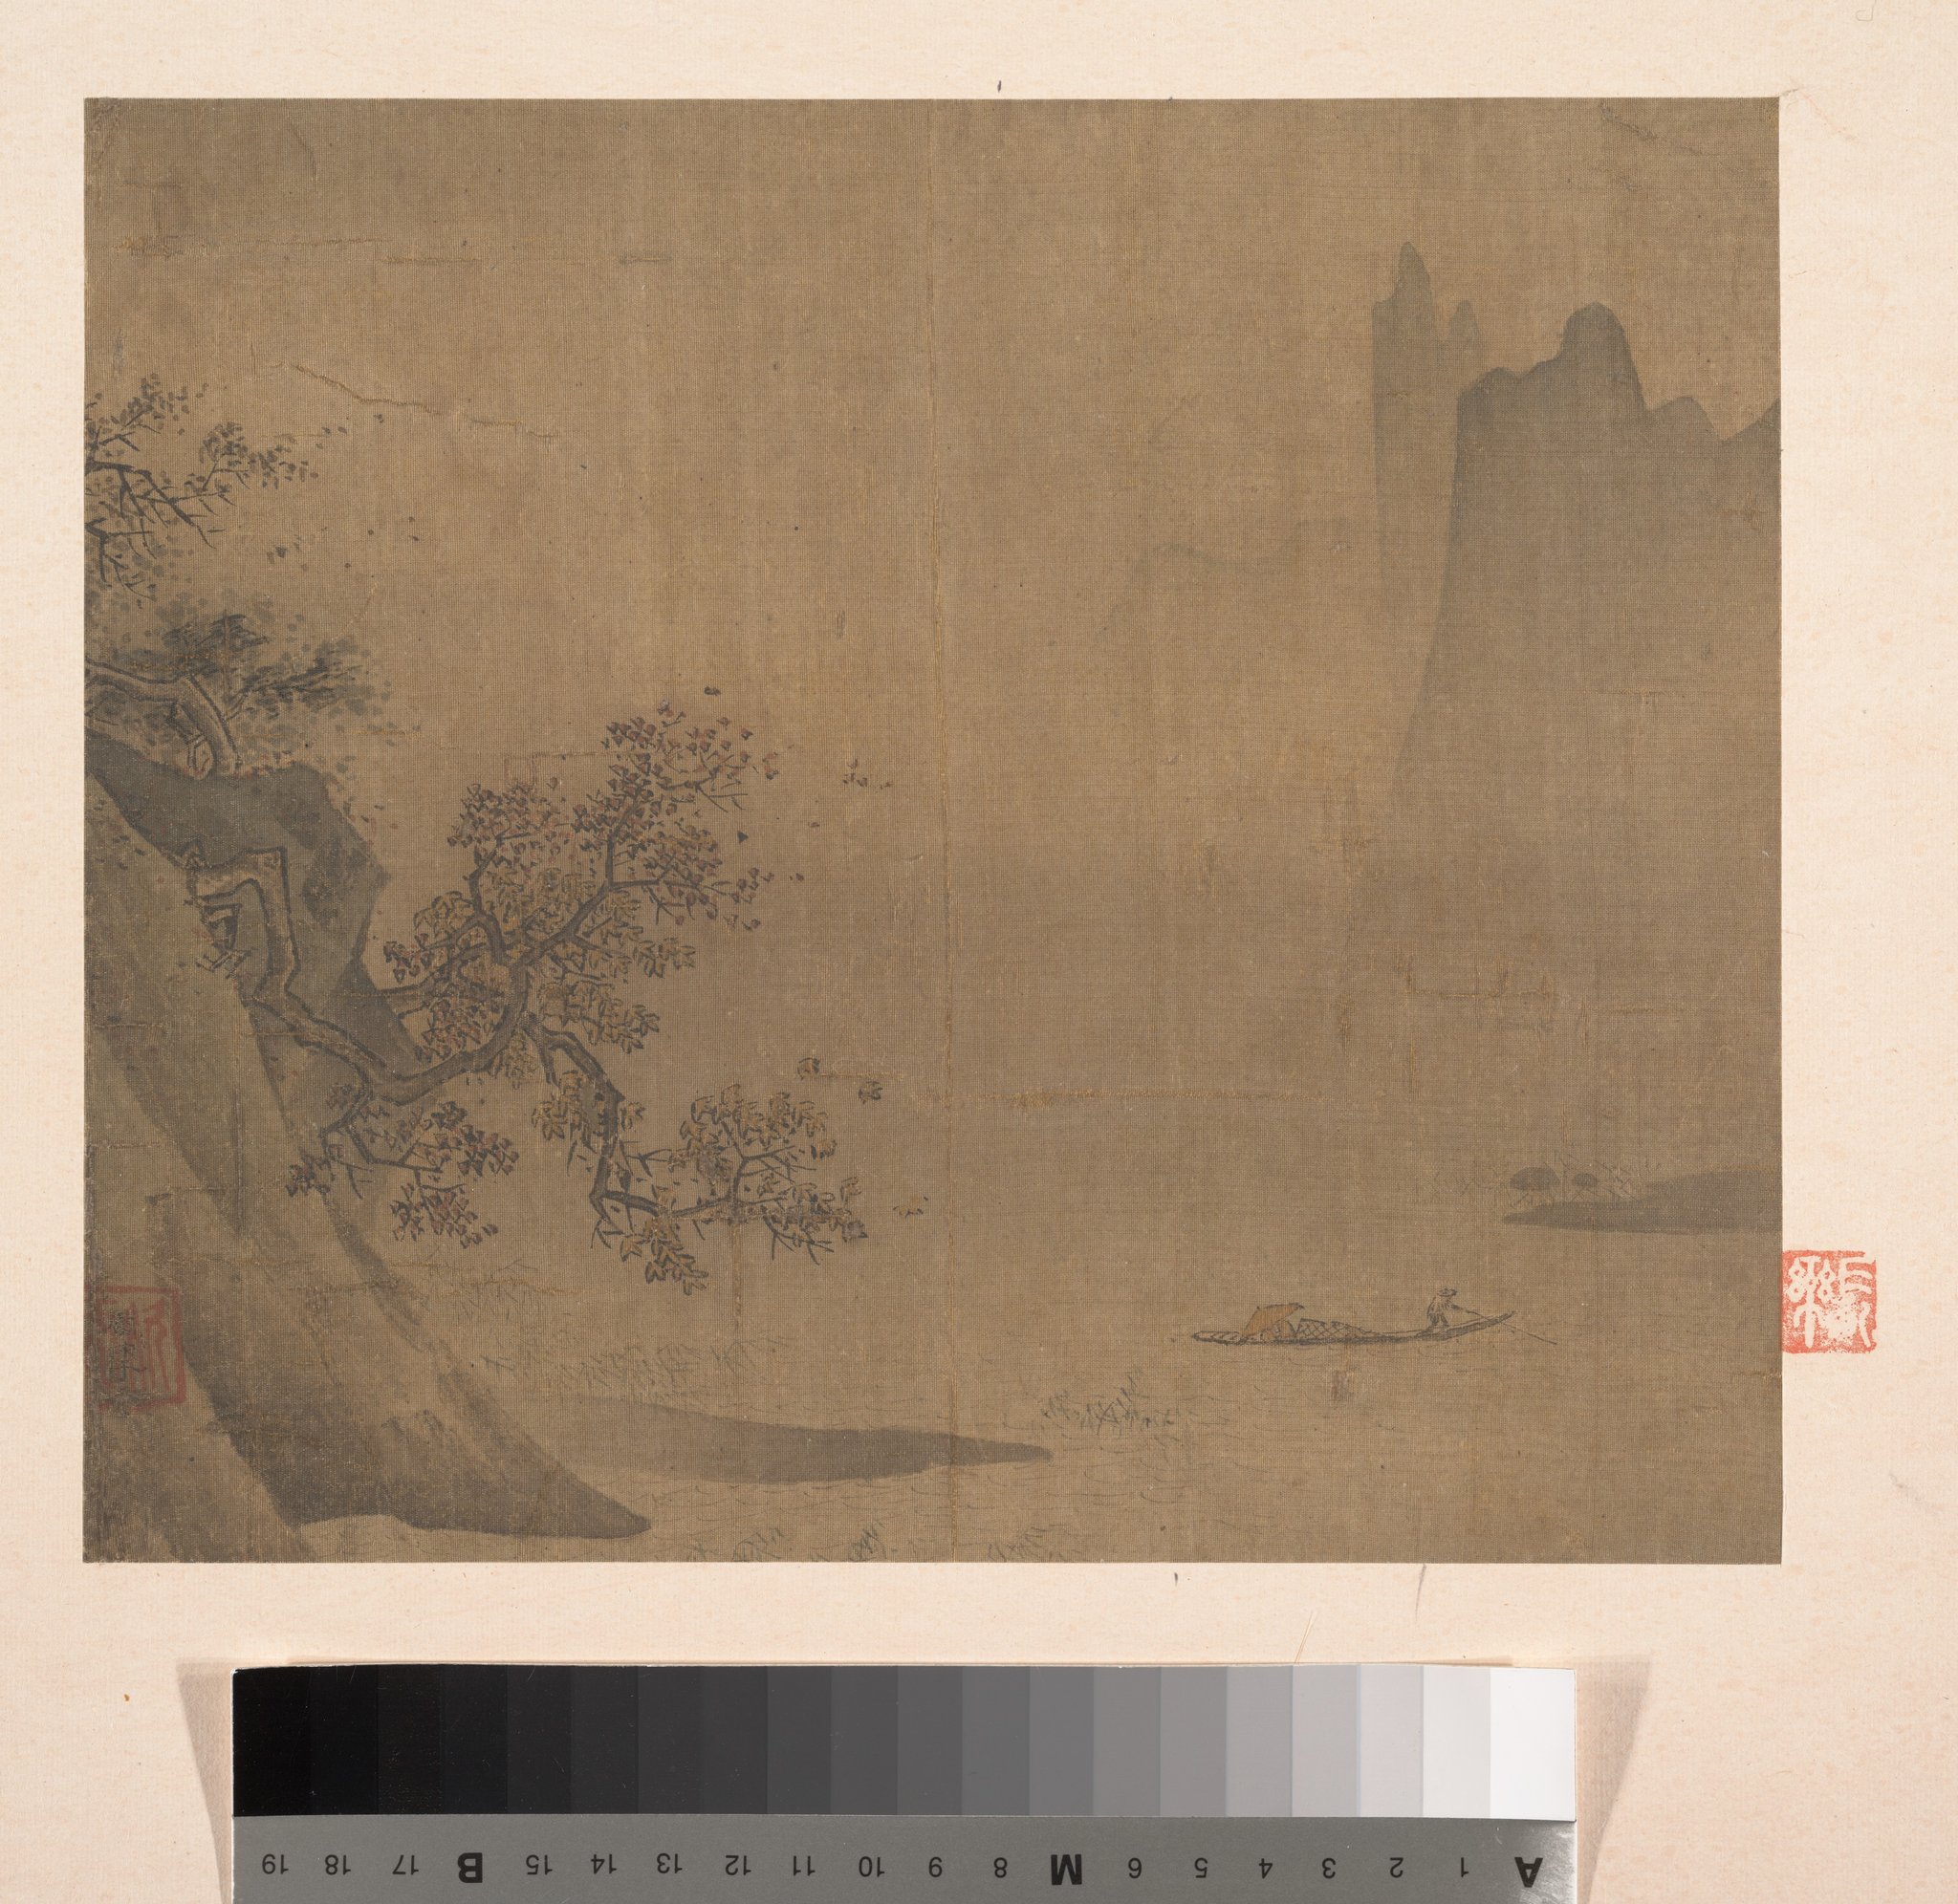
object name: album leaf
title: Rainy Landscape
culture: chinese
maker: unidentified artist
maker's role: artist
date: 1368-1644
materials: ink, silk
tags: mountains,landscapes,boats